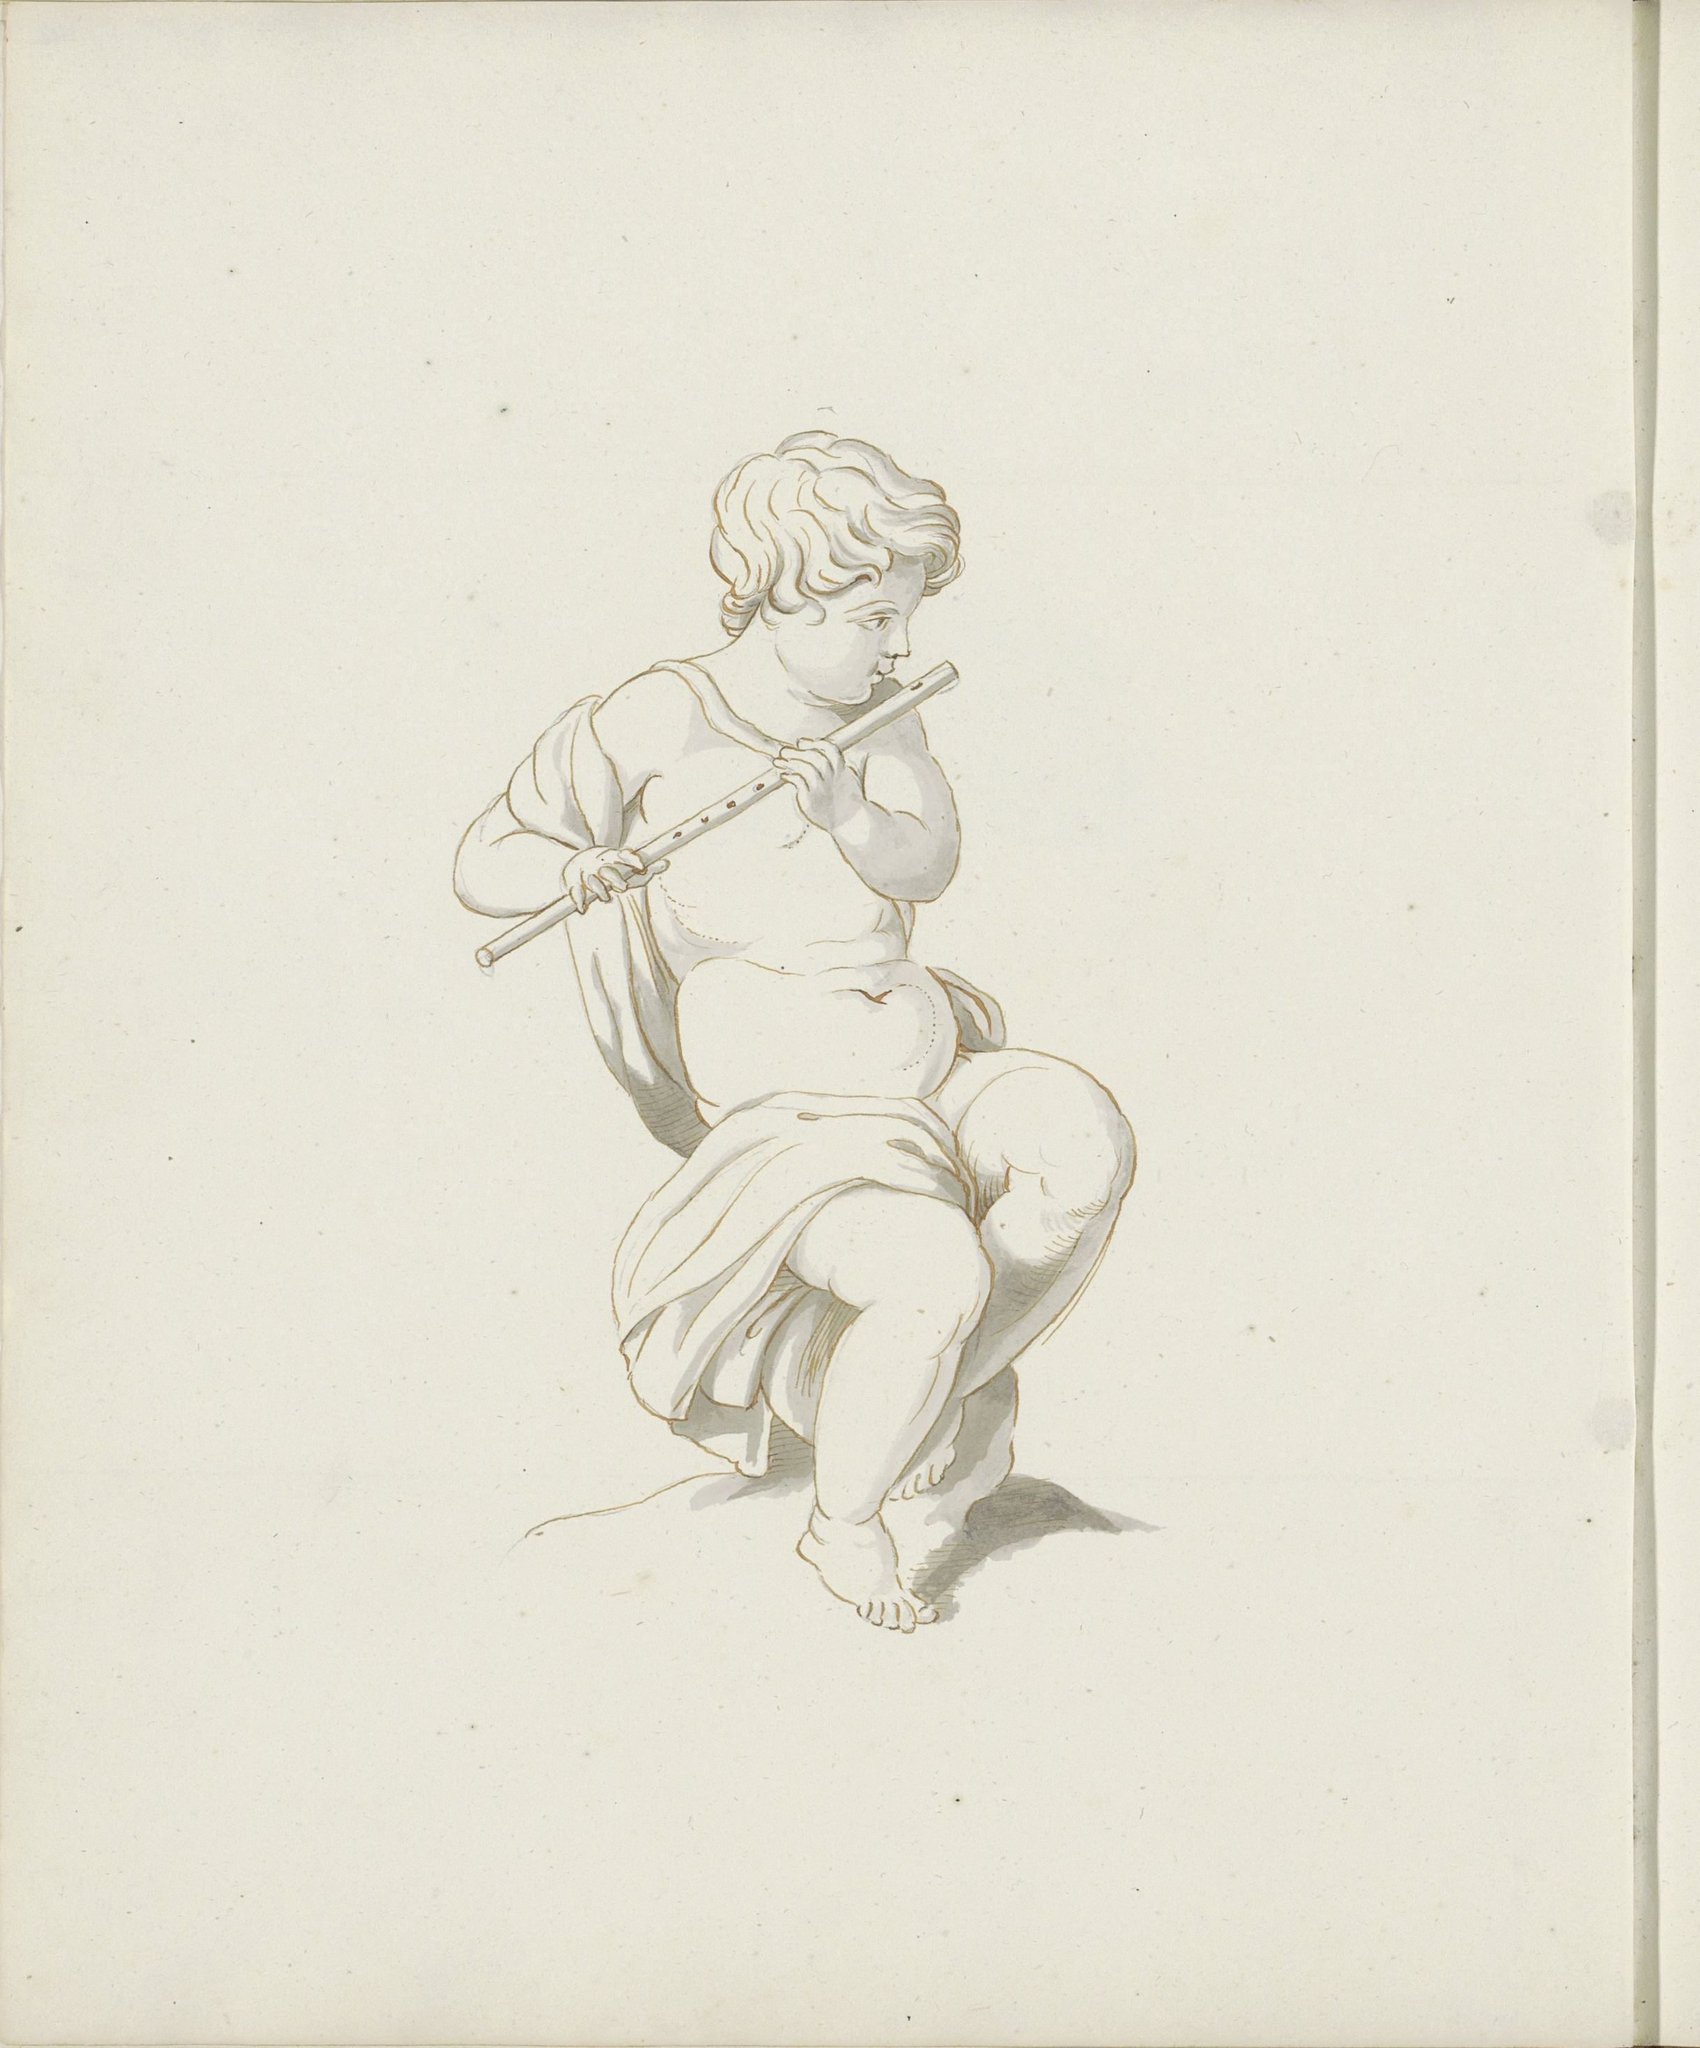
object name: sketchbook leaf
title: Op een fluit spelende putto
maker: jonkvrouw elisabeth kemper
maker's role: draughtsman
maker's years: 1799-1871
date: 1815-1852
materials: ink, paper, pencil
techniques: brush, pen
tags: cupids: 'amores', 'amoretti', 'putti', flute, aulos, tibia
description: Blad 42 verso uit een schetsboek met 94 bladen.